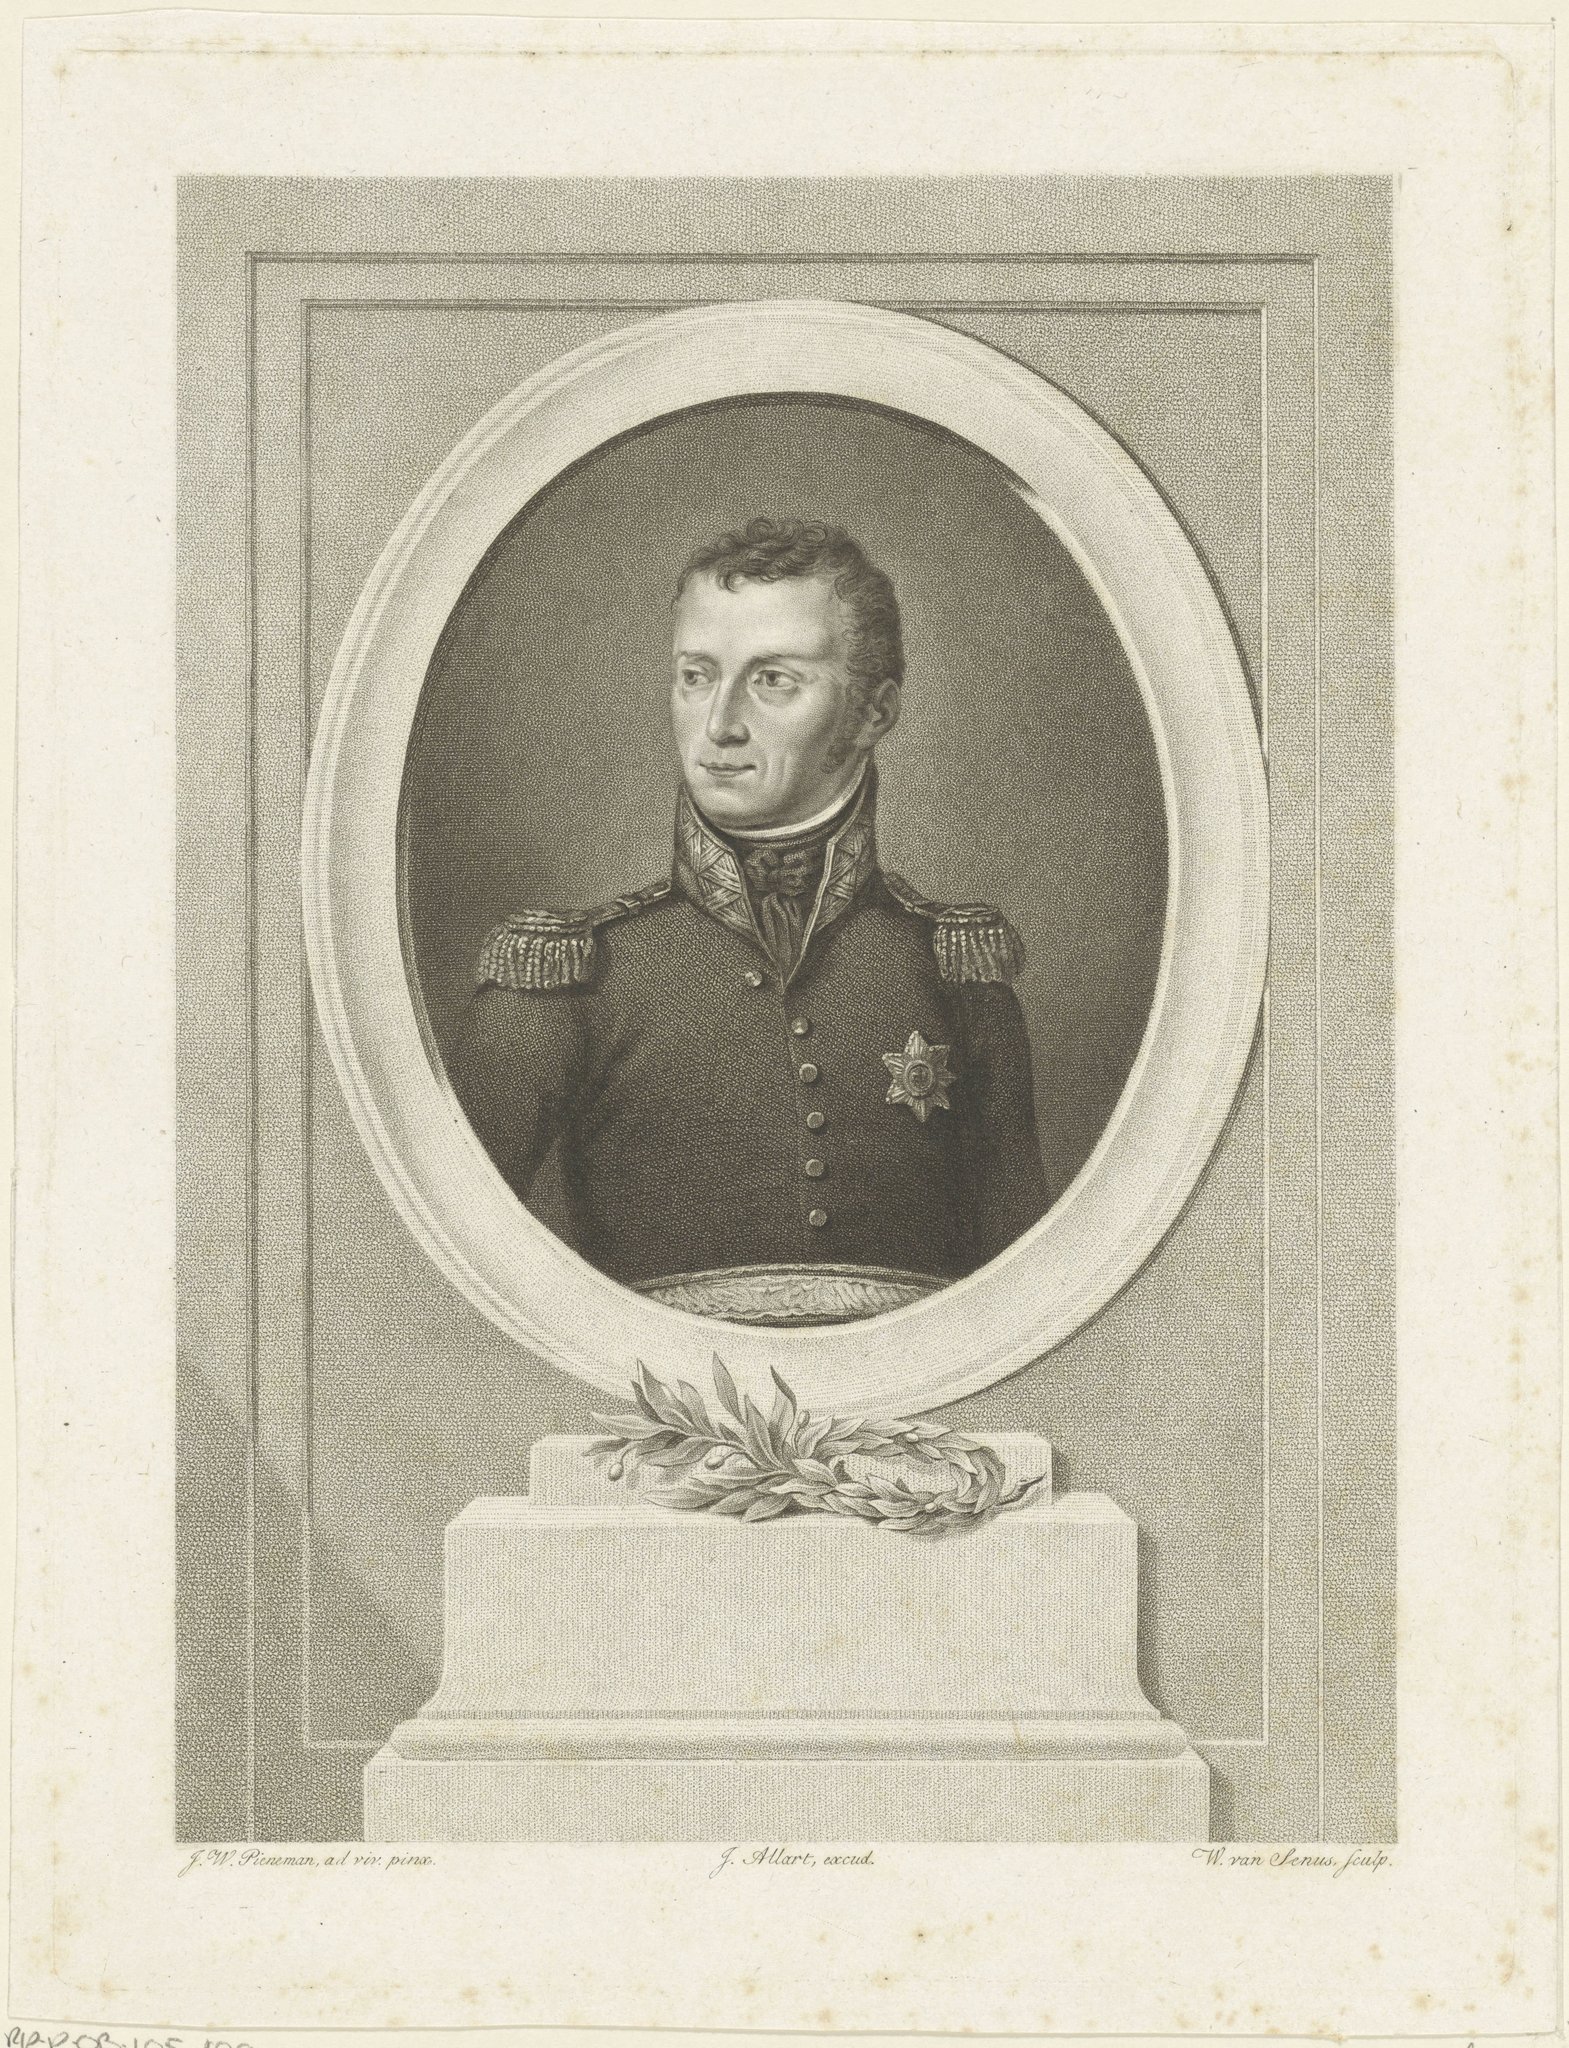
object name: print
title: Portret van Willem I Frederik, koning der Nederlanden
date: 1813-1815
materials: paper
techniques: engraving, etching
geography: netherlands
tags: berlin, william i of the netherlands, knighthood order (with name) - insignia of a knighthood order, e.g.: badge, chain (with name of order)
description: De hier vermelde titel verwijst naar de hoogst verkregen titel van de geportretteerde, niet per se naar de titel die de geportretteerde op deze voorstelling draagt.